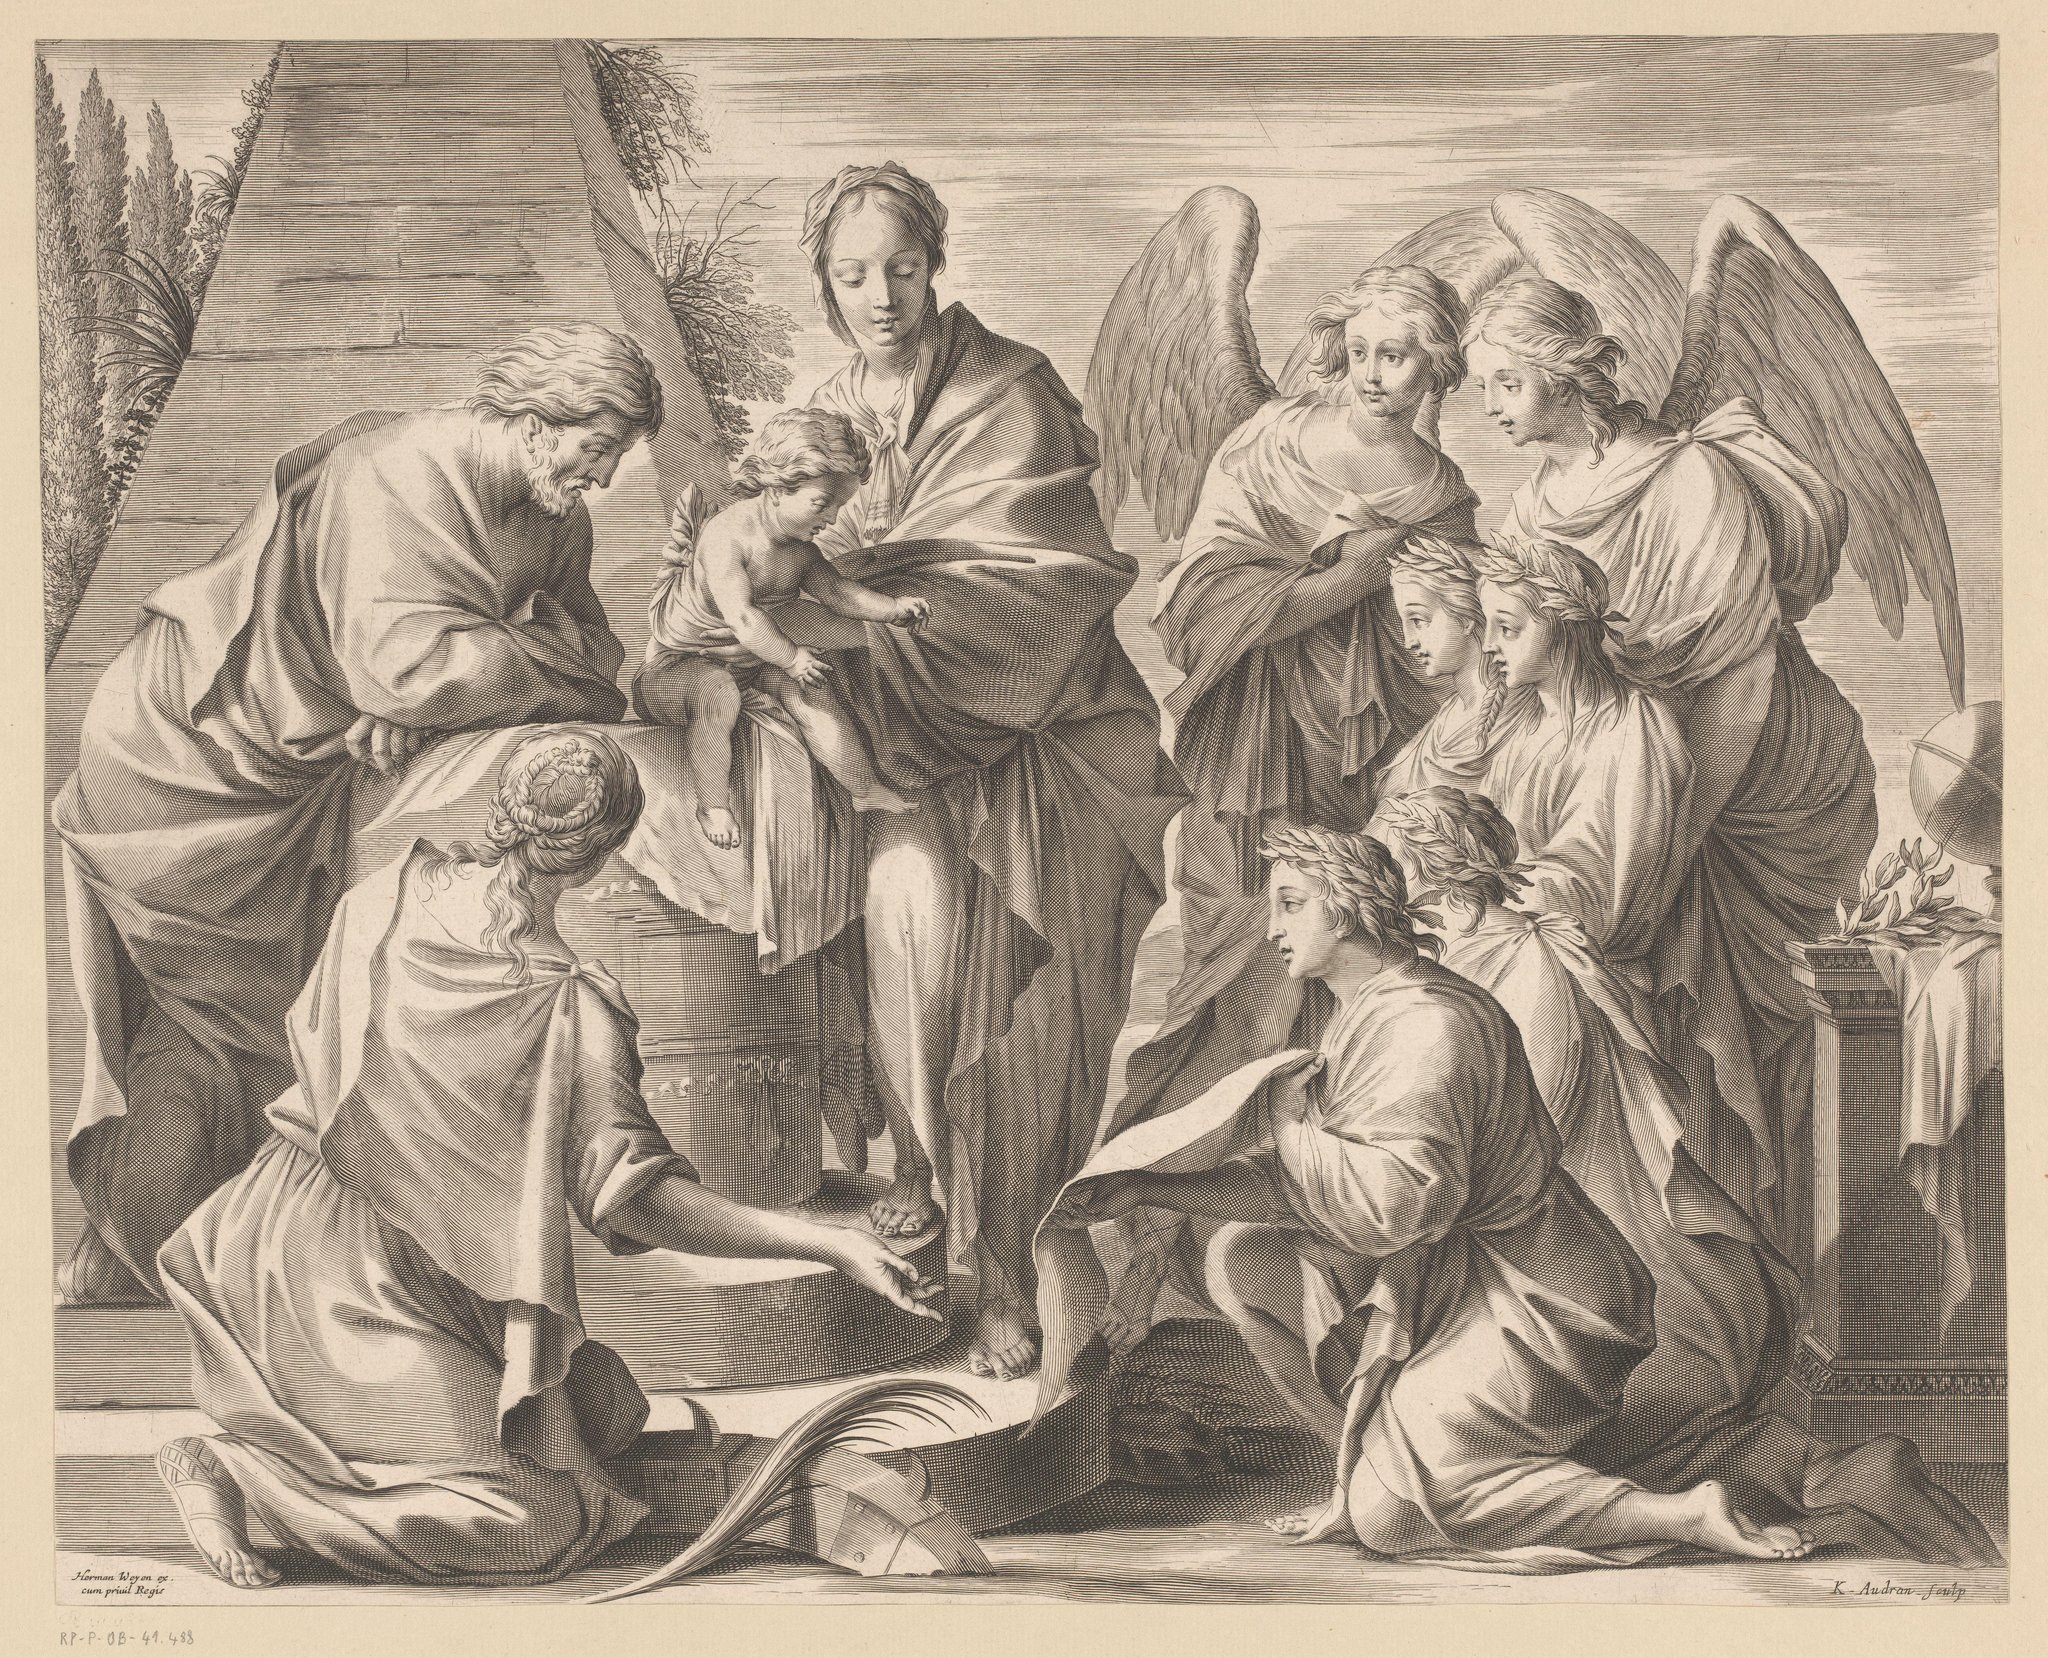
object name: print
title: Opvoeding van Christus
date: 1604-1674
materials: paper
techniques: engraving, etching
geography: france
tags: the virgin martyr catherine of alexandria; possible attributes: book, crown, emperor maxentius, palm-branch, ring, sword, wheel, education of the christ-child, globe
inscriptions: collector's mark: Lugt 240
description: Het Christuskind wordt geflankeerd door Maria en Jozef terwijl Catharina van Alexandrië geknield naast hem zit en wijst naar een banderol die wordt vastgehouden door een geknielde jongen met lauwerkrans. Rechts van deze jongen zijn nog enkele kinderen met lauwerkransen afgebeeld. Achter hen staan twee engelen bij een sokkel met globe en lauwerkrans.